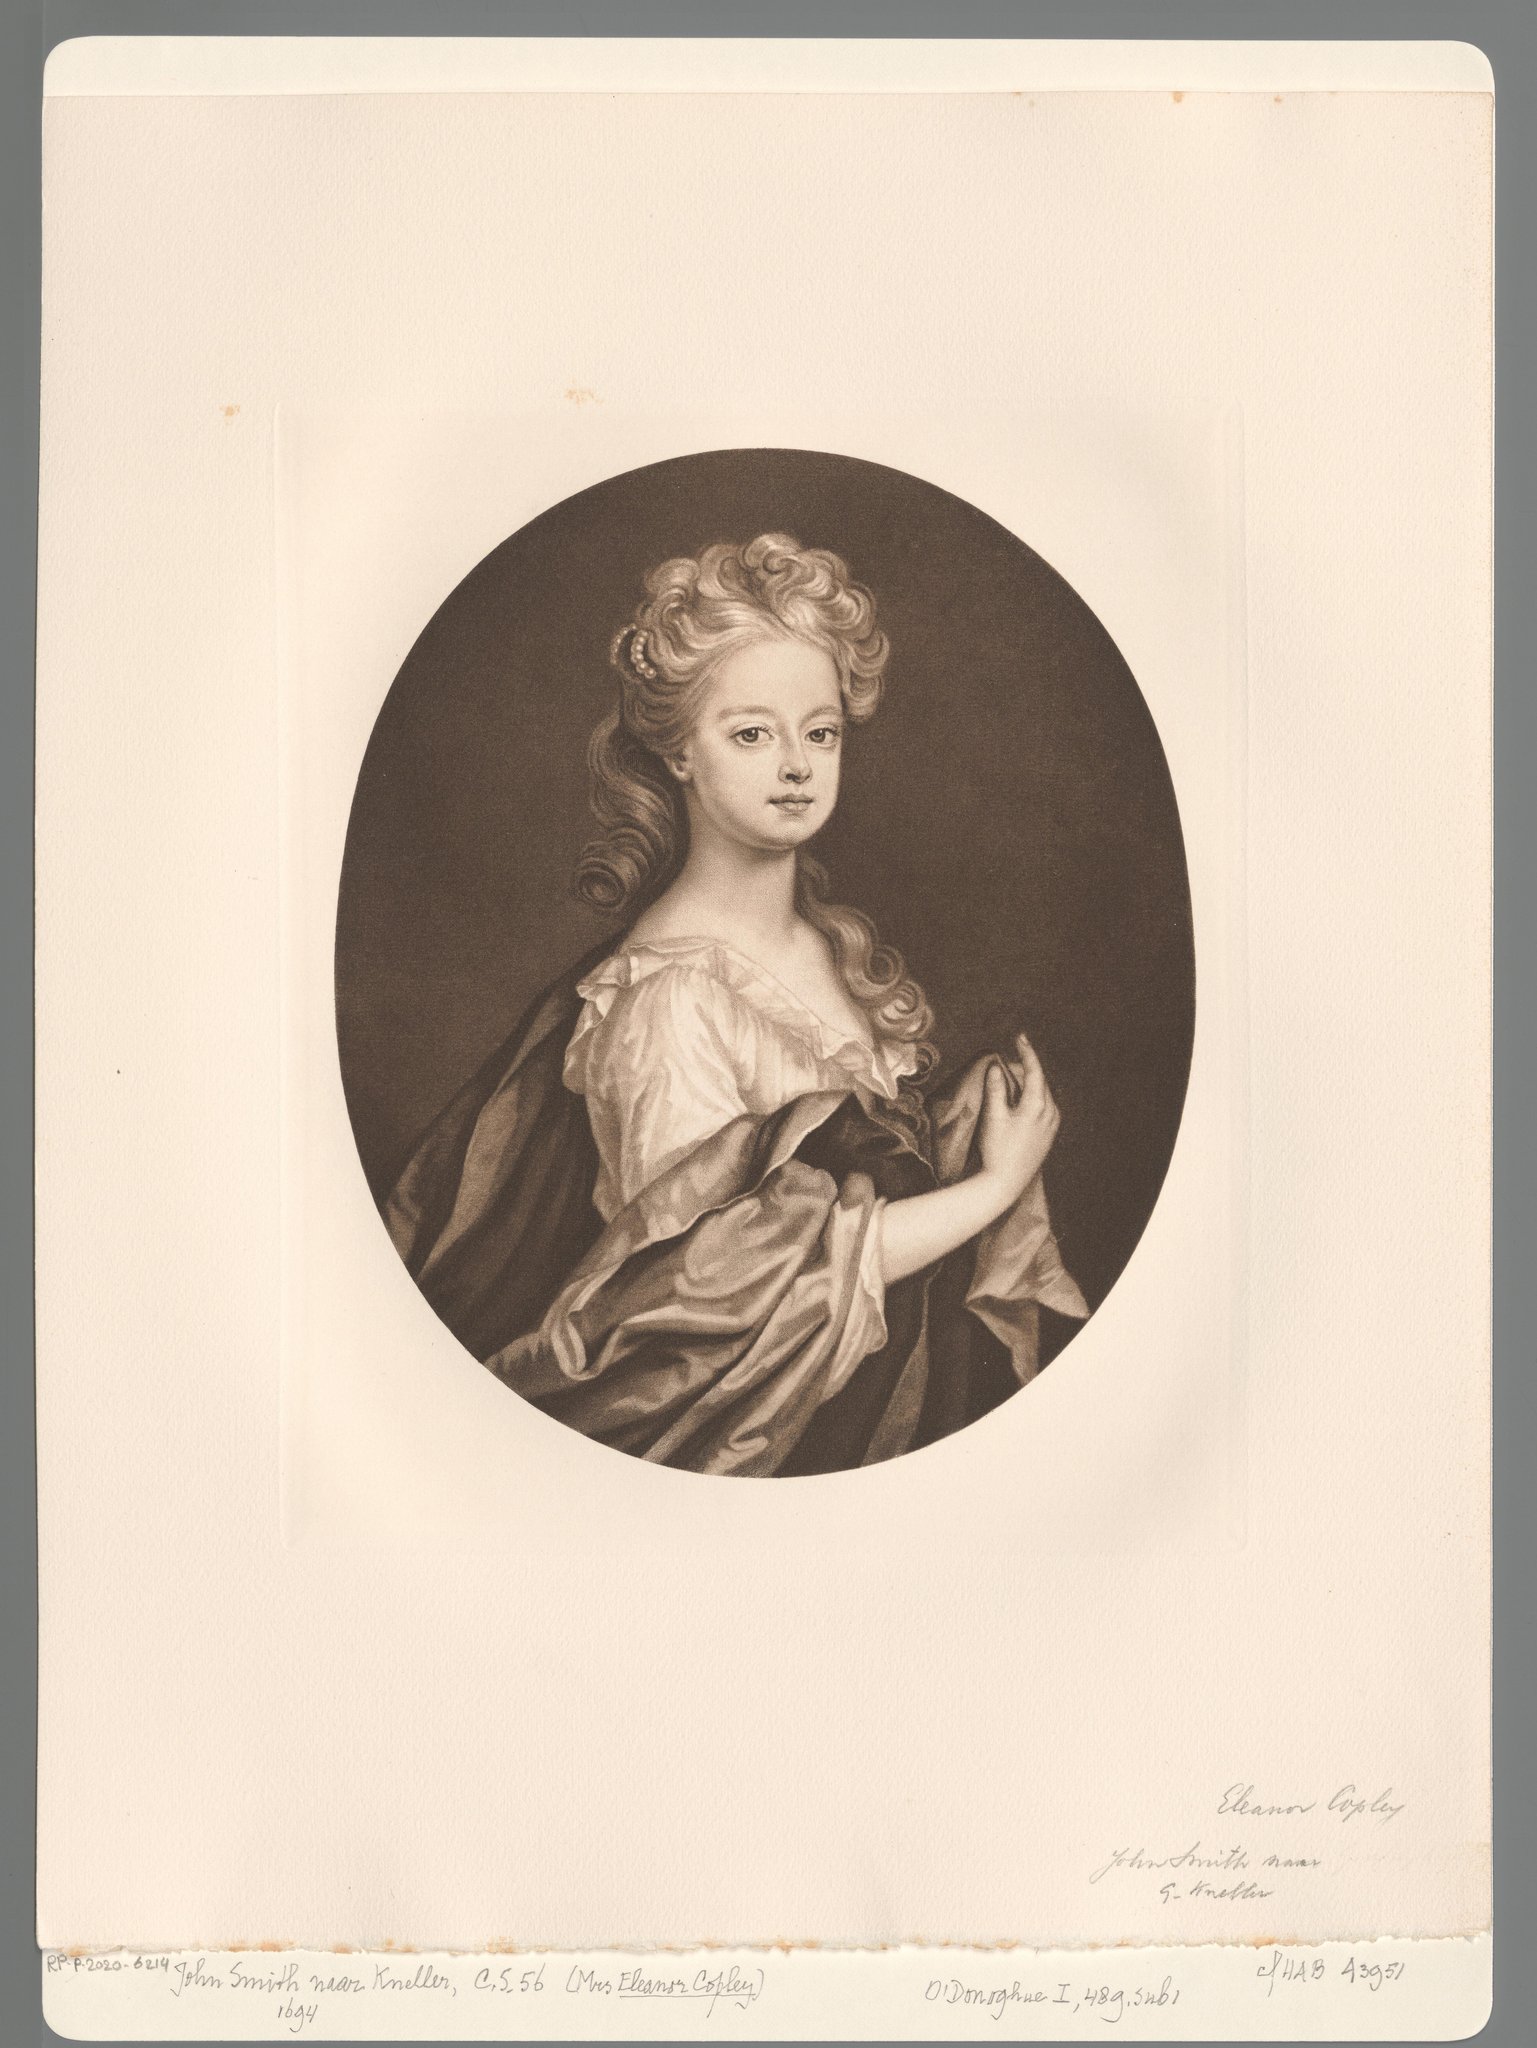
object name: photomechanical print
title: Portret van Elinor Copley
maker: Anonymous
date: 1870-1915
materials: paper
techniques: photoaquatint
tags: historical persons - bb - woman